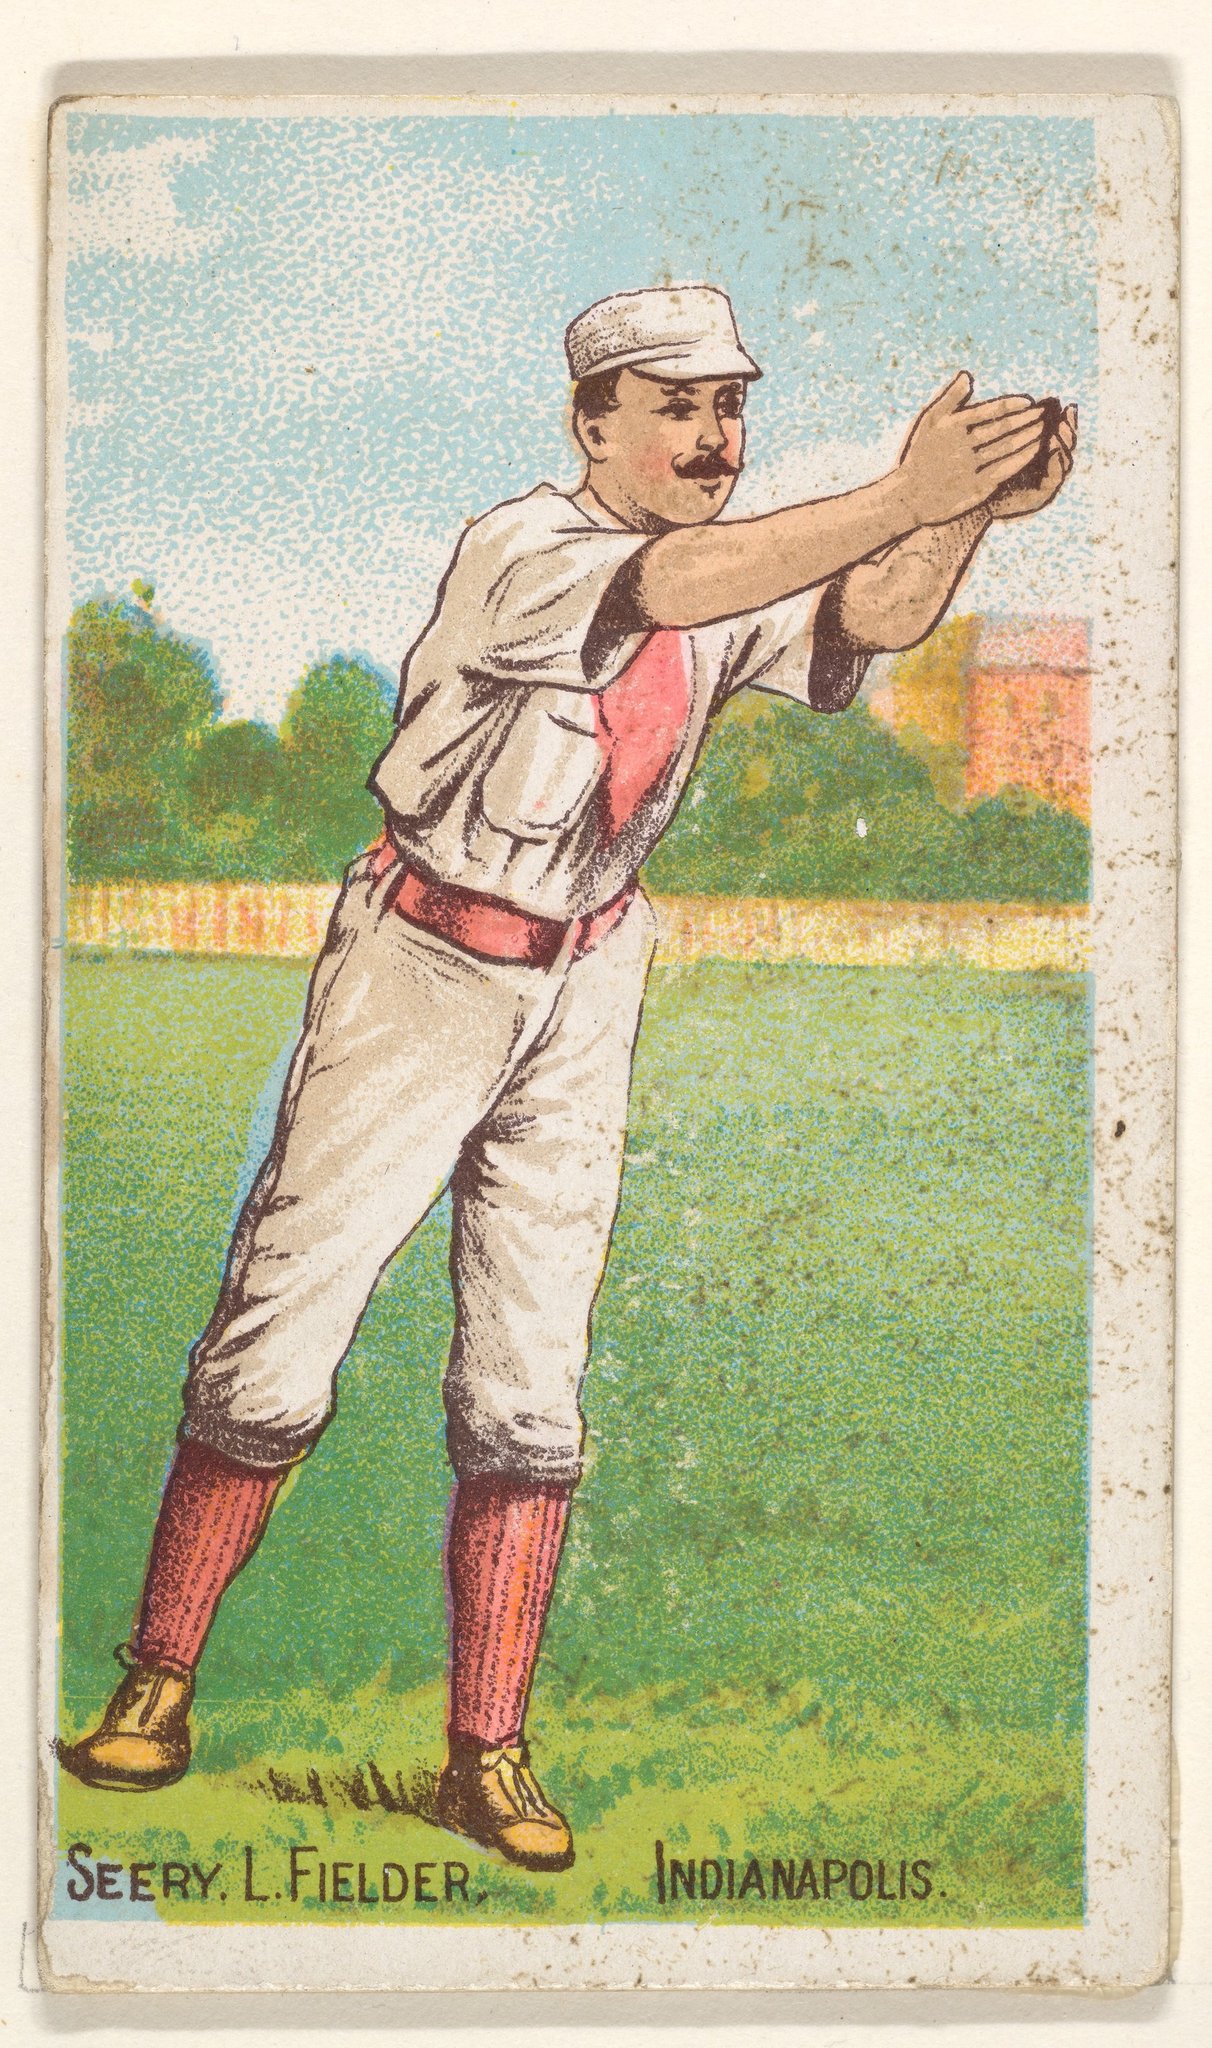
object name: baseball card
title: Seery (Hands Outstretched), Left Field, Indianapolis, from the Gold Coin series (N284) for Gold Coin Chewing Tobacco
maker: d. buchner & co., new york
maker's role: publisher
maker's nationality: american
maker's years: 1850-1900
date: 1887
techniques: color lithograph, drawing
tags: men,baseball,athletes